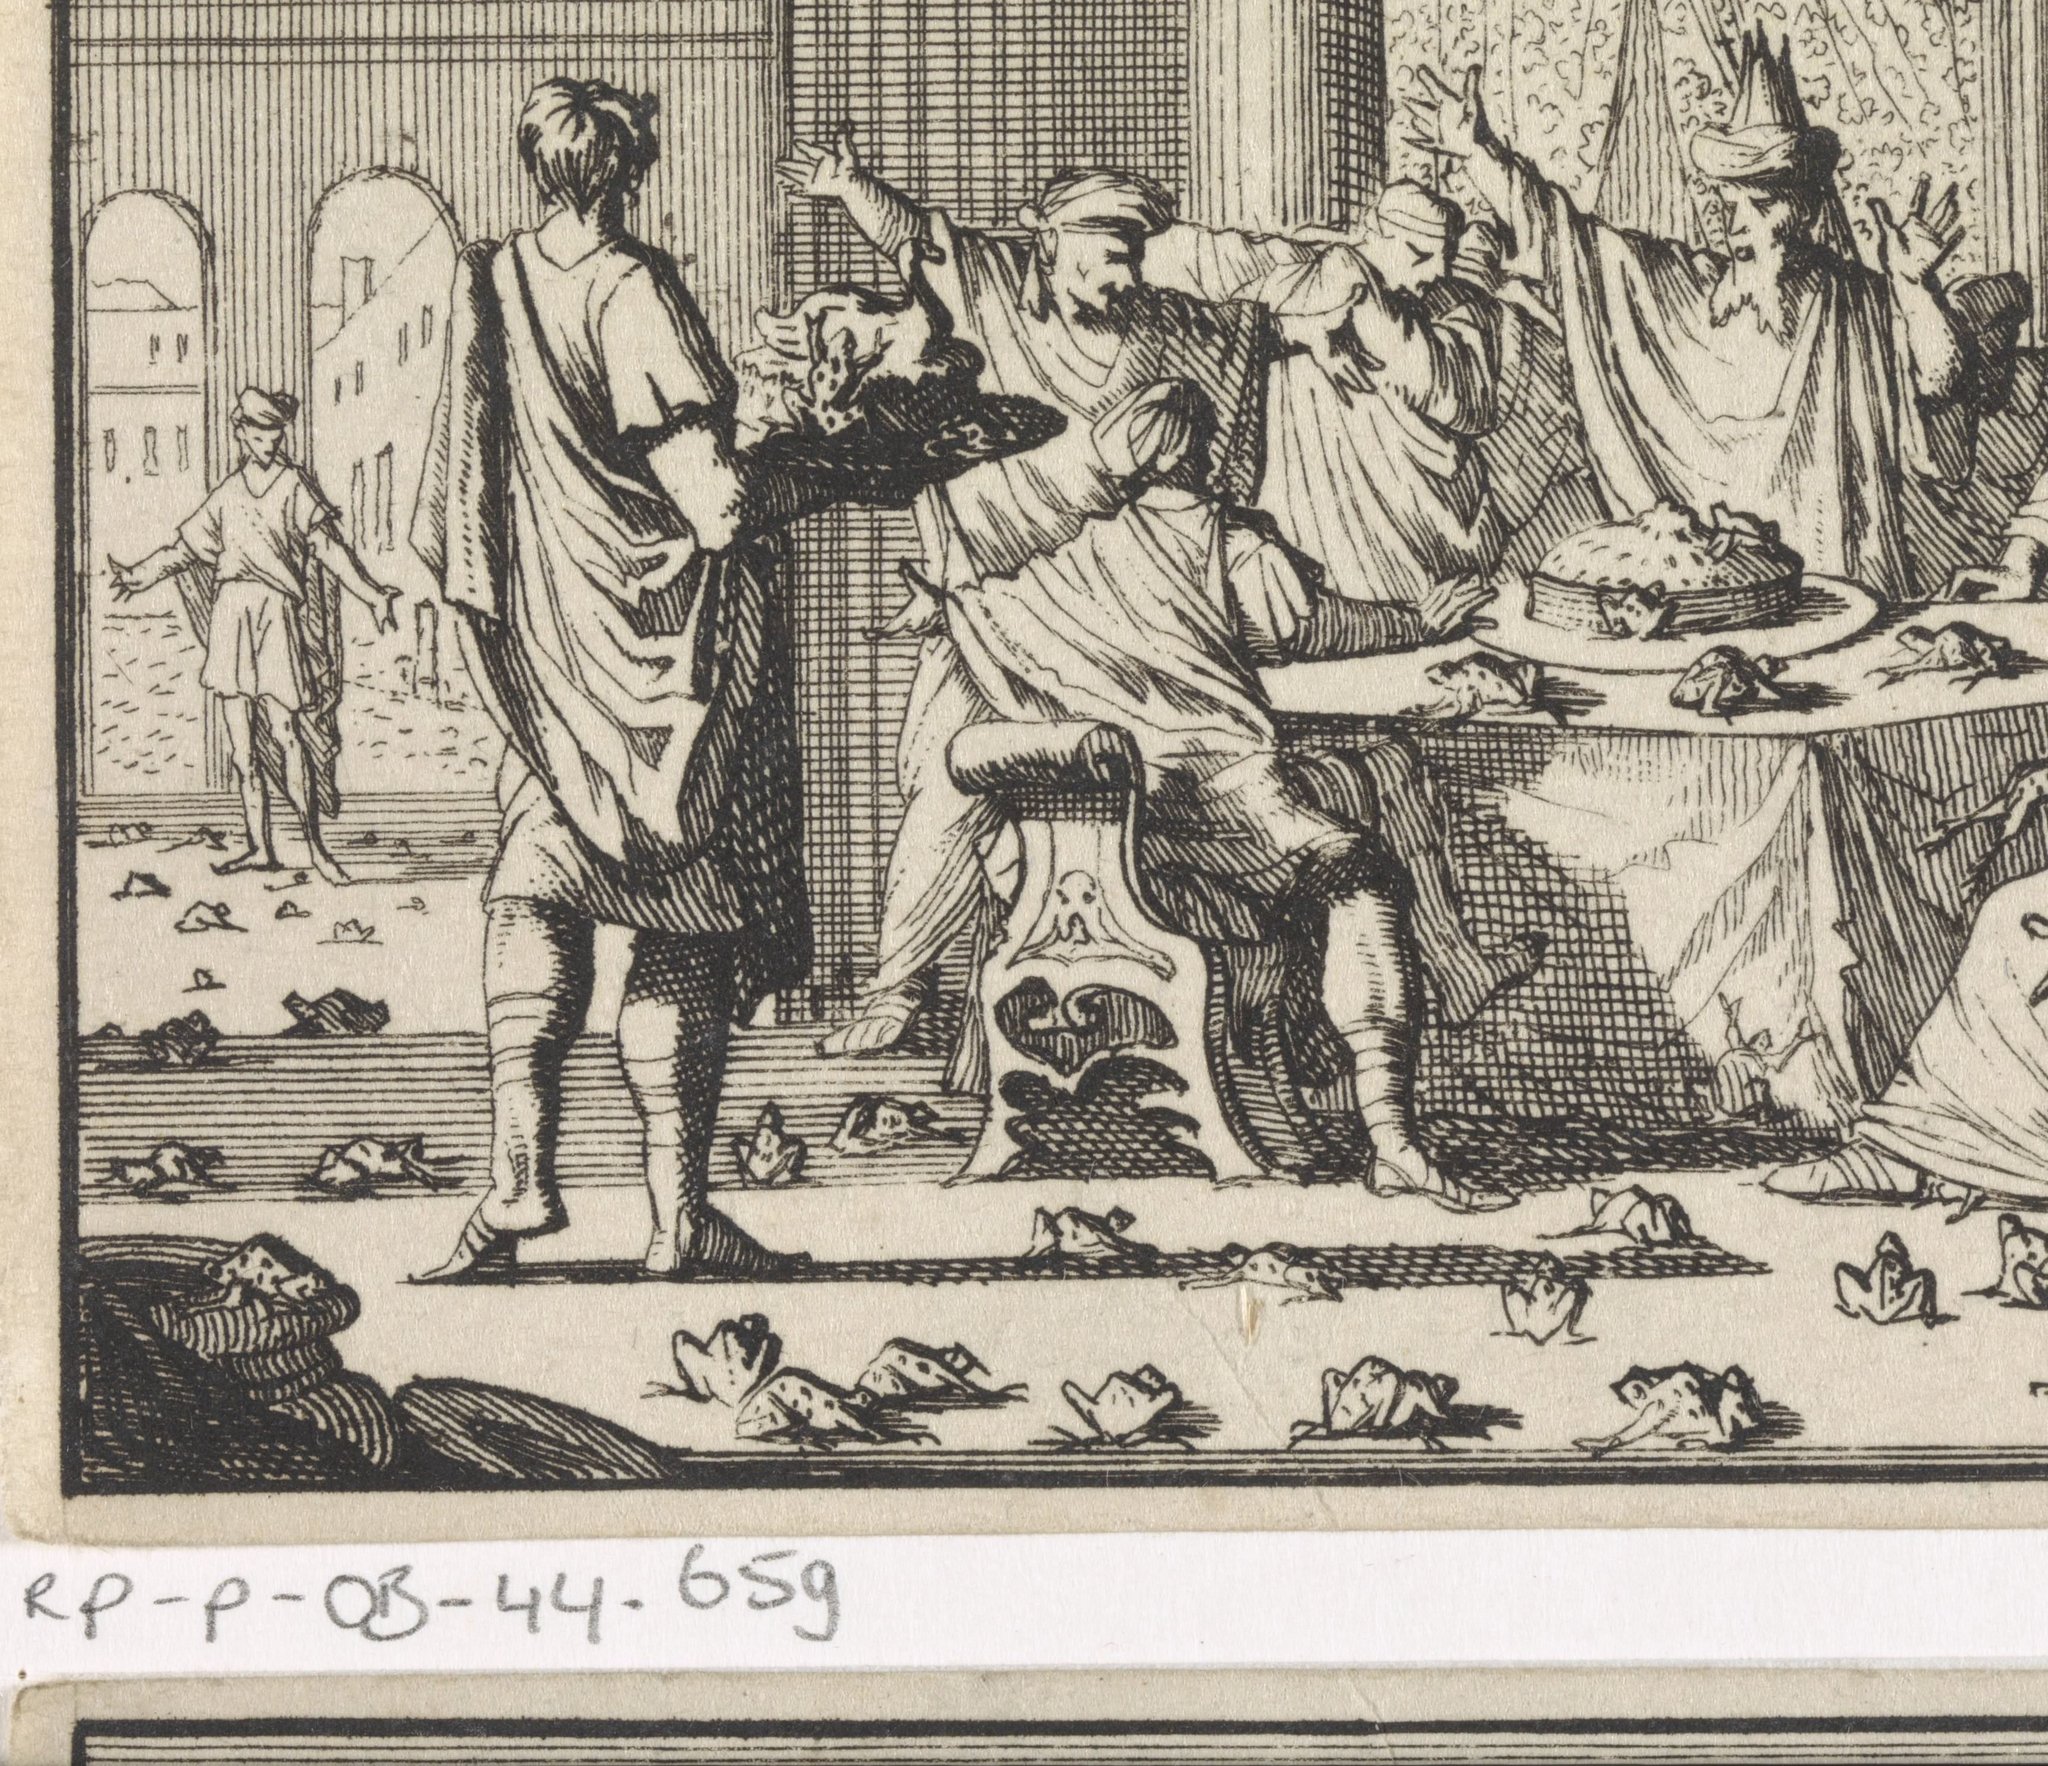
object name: print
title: Plaag van de kikkers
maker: caspar luyken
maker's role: draughtsman, print maker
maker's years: 1672-1708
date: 1698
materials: paper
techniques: etching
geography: amsterdam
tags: the plague of frogs: aaron stretches out his hand over the water of egypt; frogs come out and cover the land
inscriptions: collector's mark: Lugt 2228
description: Proefdruk van illustratie uit: Josephus, Flavius. XX. boeken van de oude geschiedenissen der joden, 4 delen. Amsterdam: Barent Visscher, Willem de Coup, Willem van Lamsveld, Andries van Damme, 1698, dl. I.